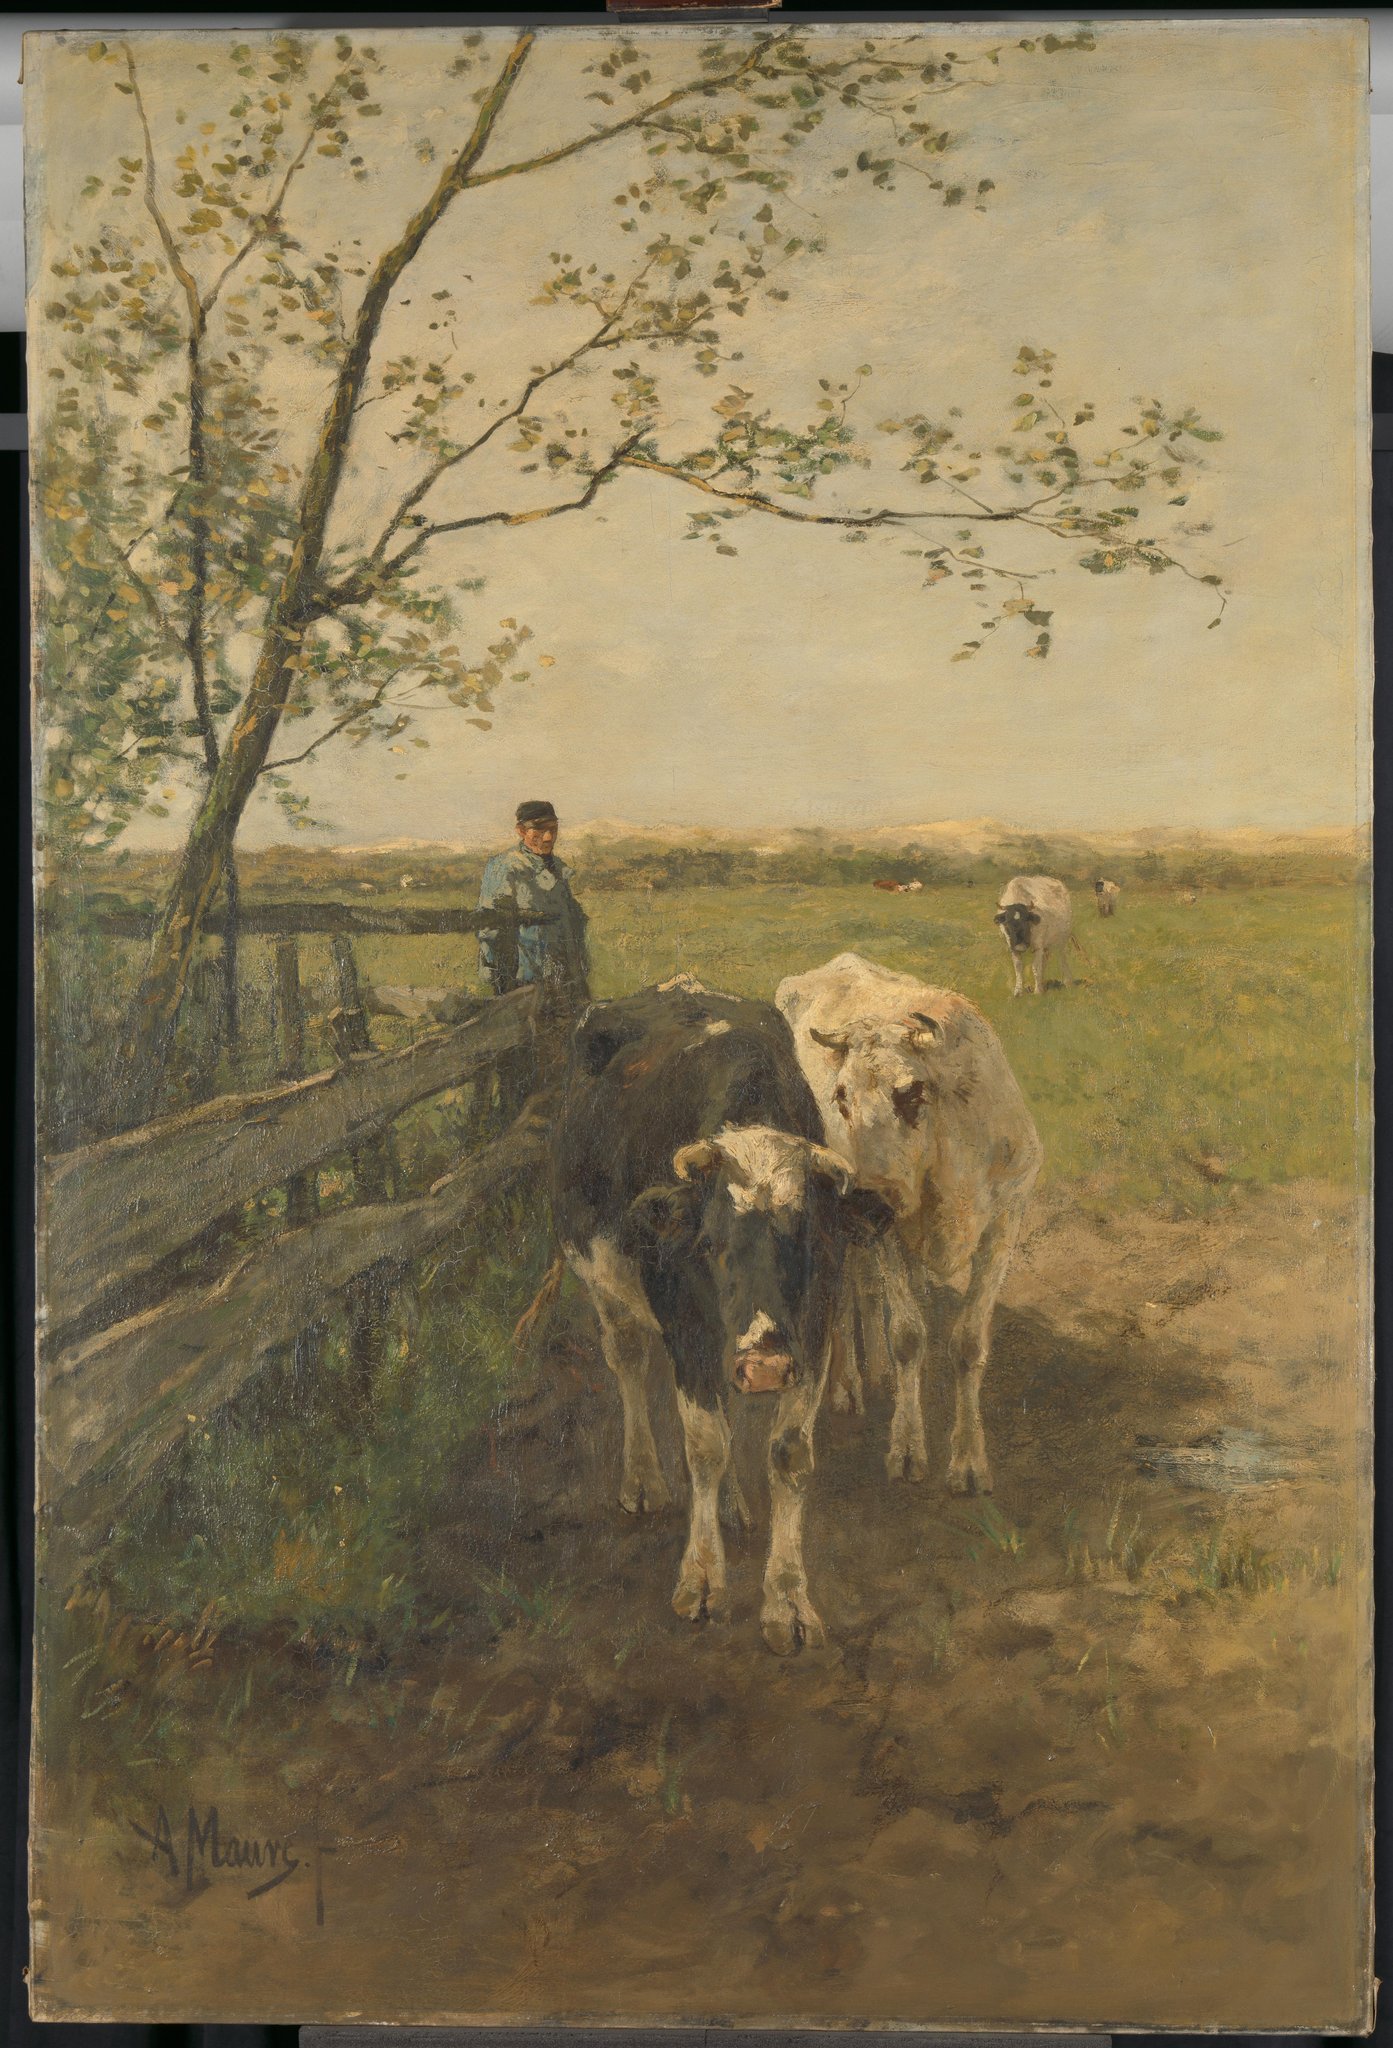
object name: painting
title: De melkbocht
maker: anton mauve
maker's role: draughtsman, painter, print maker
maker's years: 1838-1888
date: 1870-1888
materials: canvas, oil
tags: cow, milking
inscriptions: signature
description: De melkbocht. Weidelandschap met koeien die door een boer langs een hek naar de melkbocht gedreven worden.